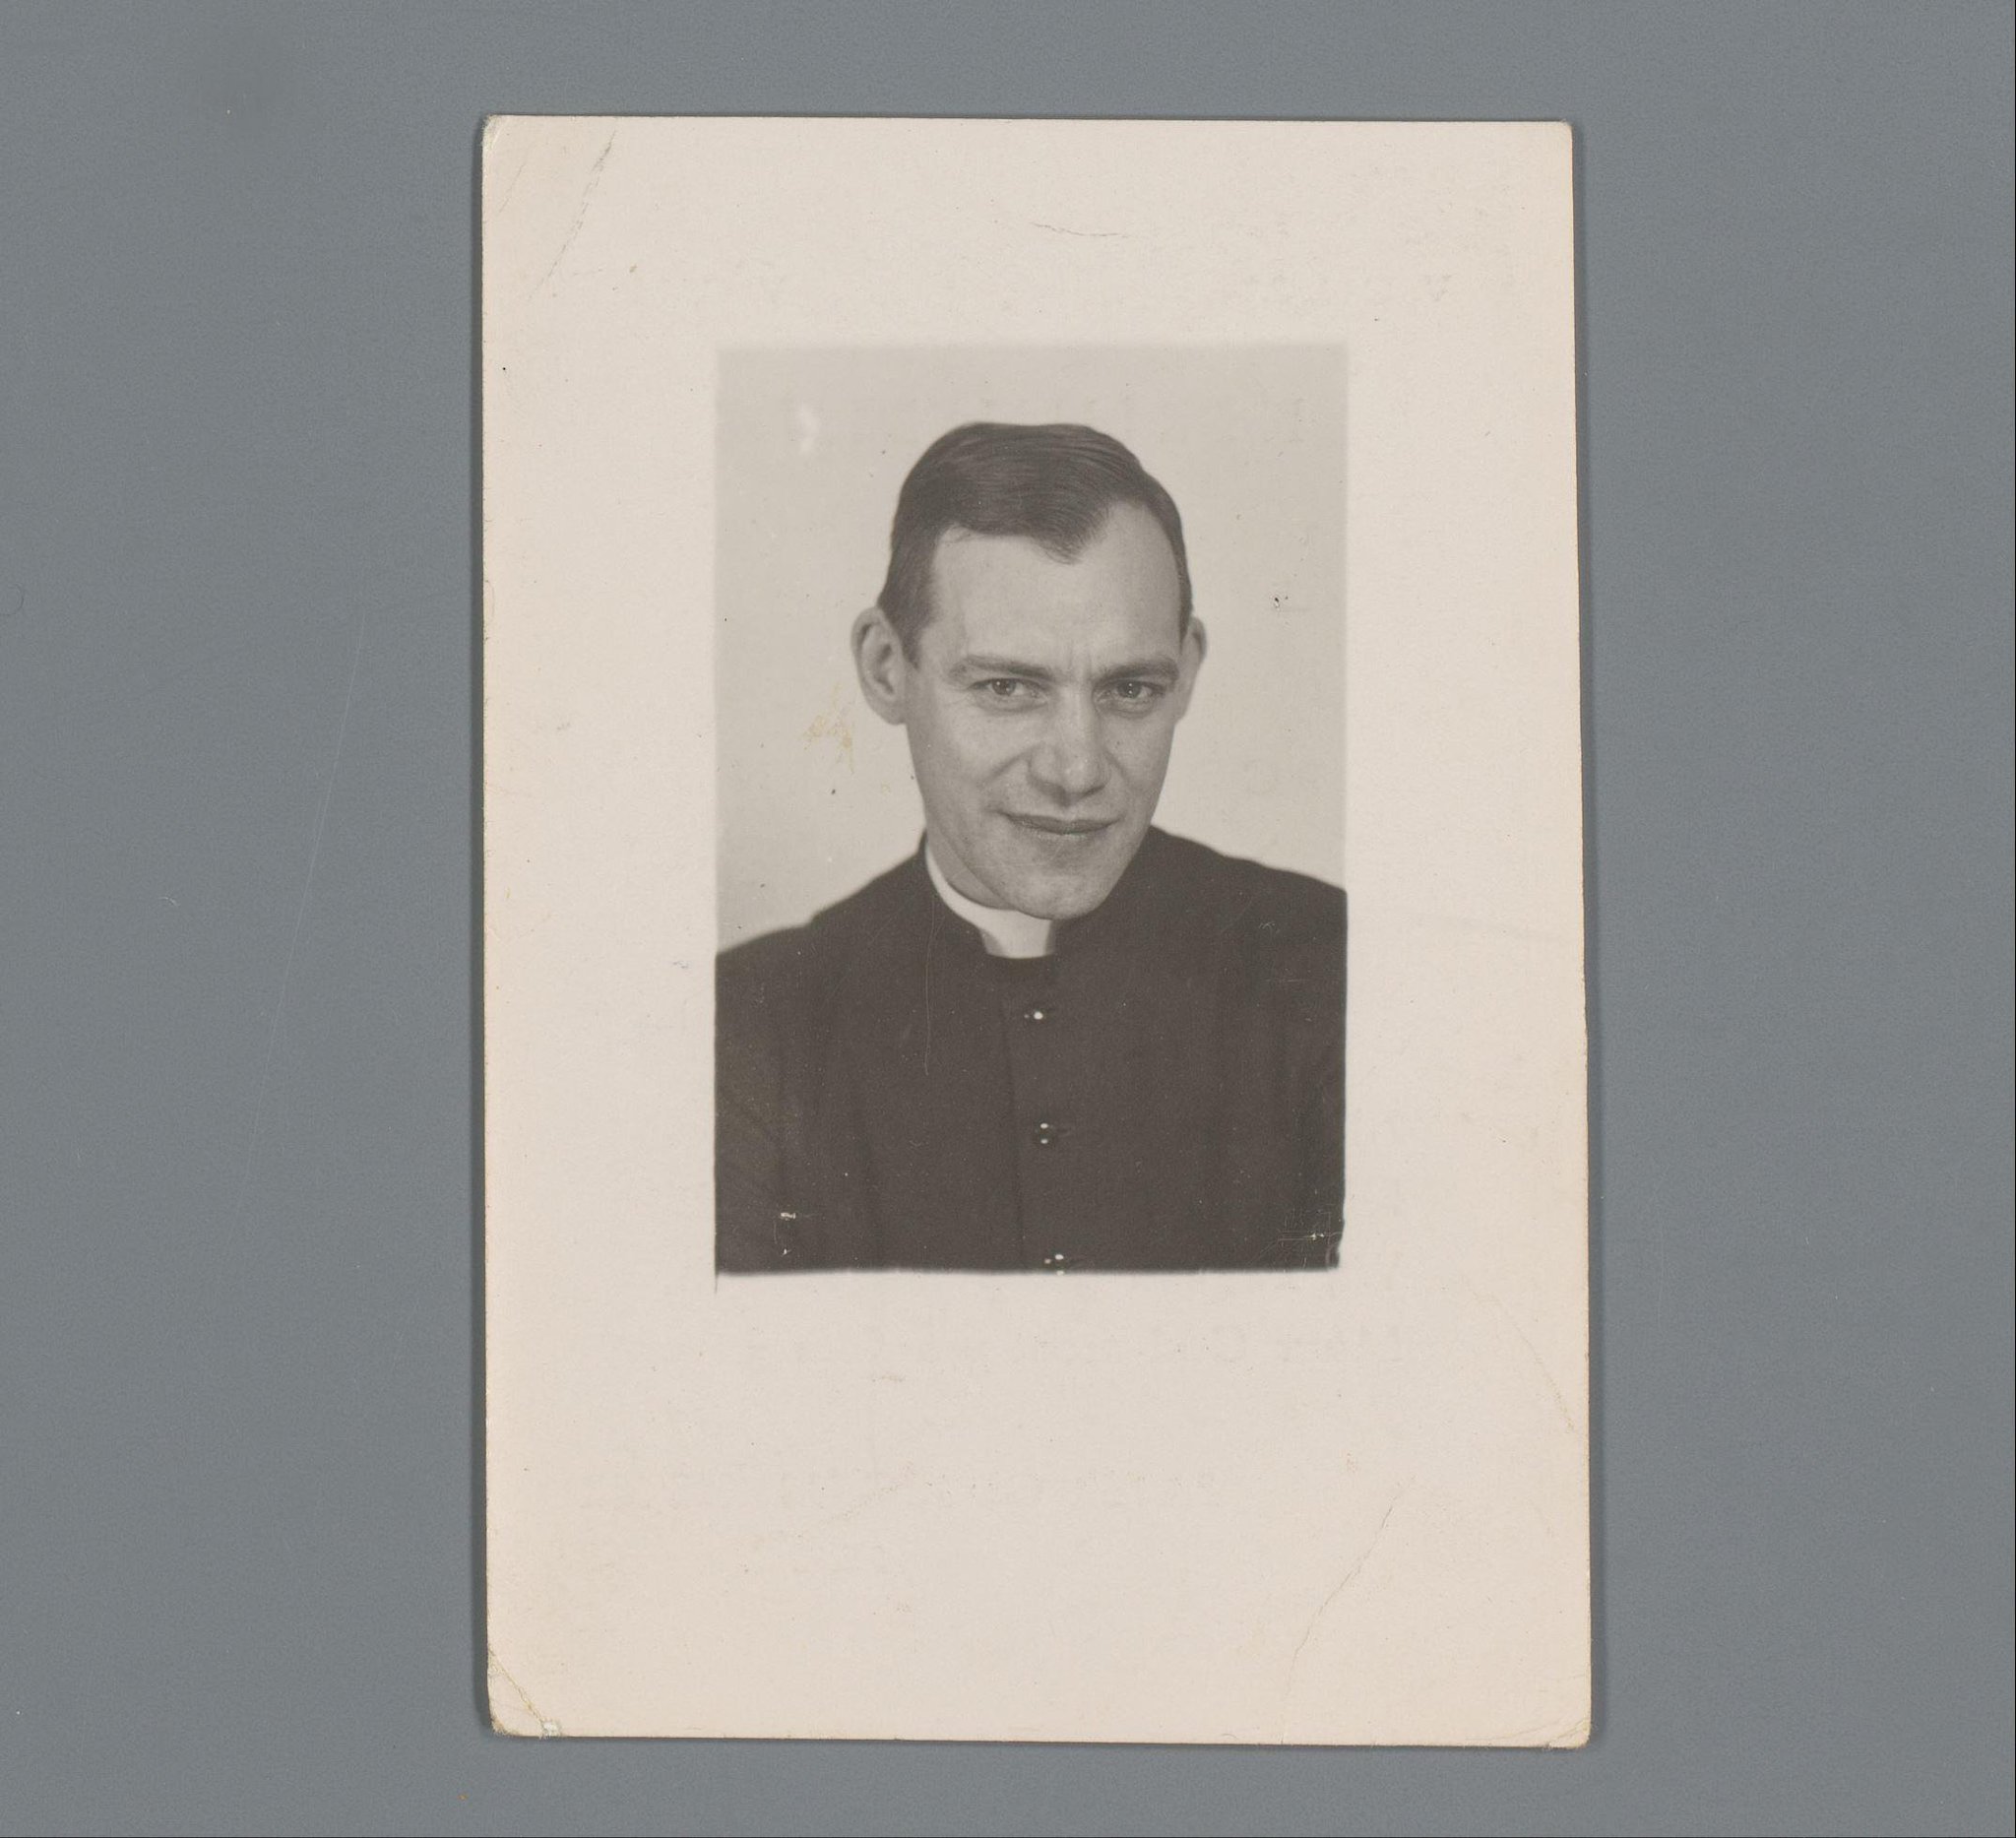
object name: photograph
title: Portret van Pater Georgius Kester ter herinnering aan zijn vertrek naar de Cookeilanden in april 1947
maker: Anonymous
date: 1904-1947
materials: paper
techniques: gelatin silver print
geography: netherlands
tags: historical persons, organization, functionaries and dignitaries in roman catholic church; clergy in general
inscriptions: inscription: ‘V.C.J.S./ V.C.M.I./ HERINNERING/ aan mijn/ VERTREK/ naar de/ COOKEILANDEN/ (Stille Zuidzee)/ APRIL 1947./ (...)/ PATER GEORGIUS KESTER/ SS. CC.’